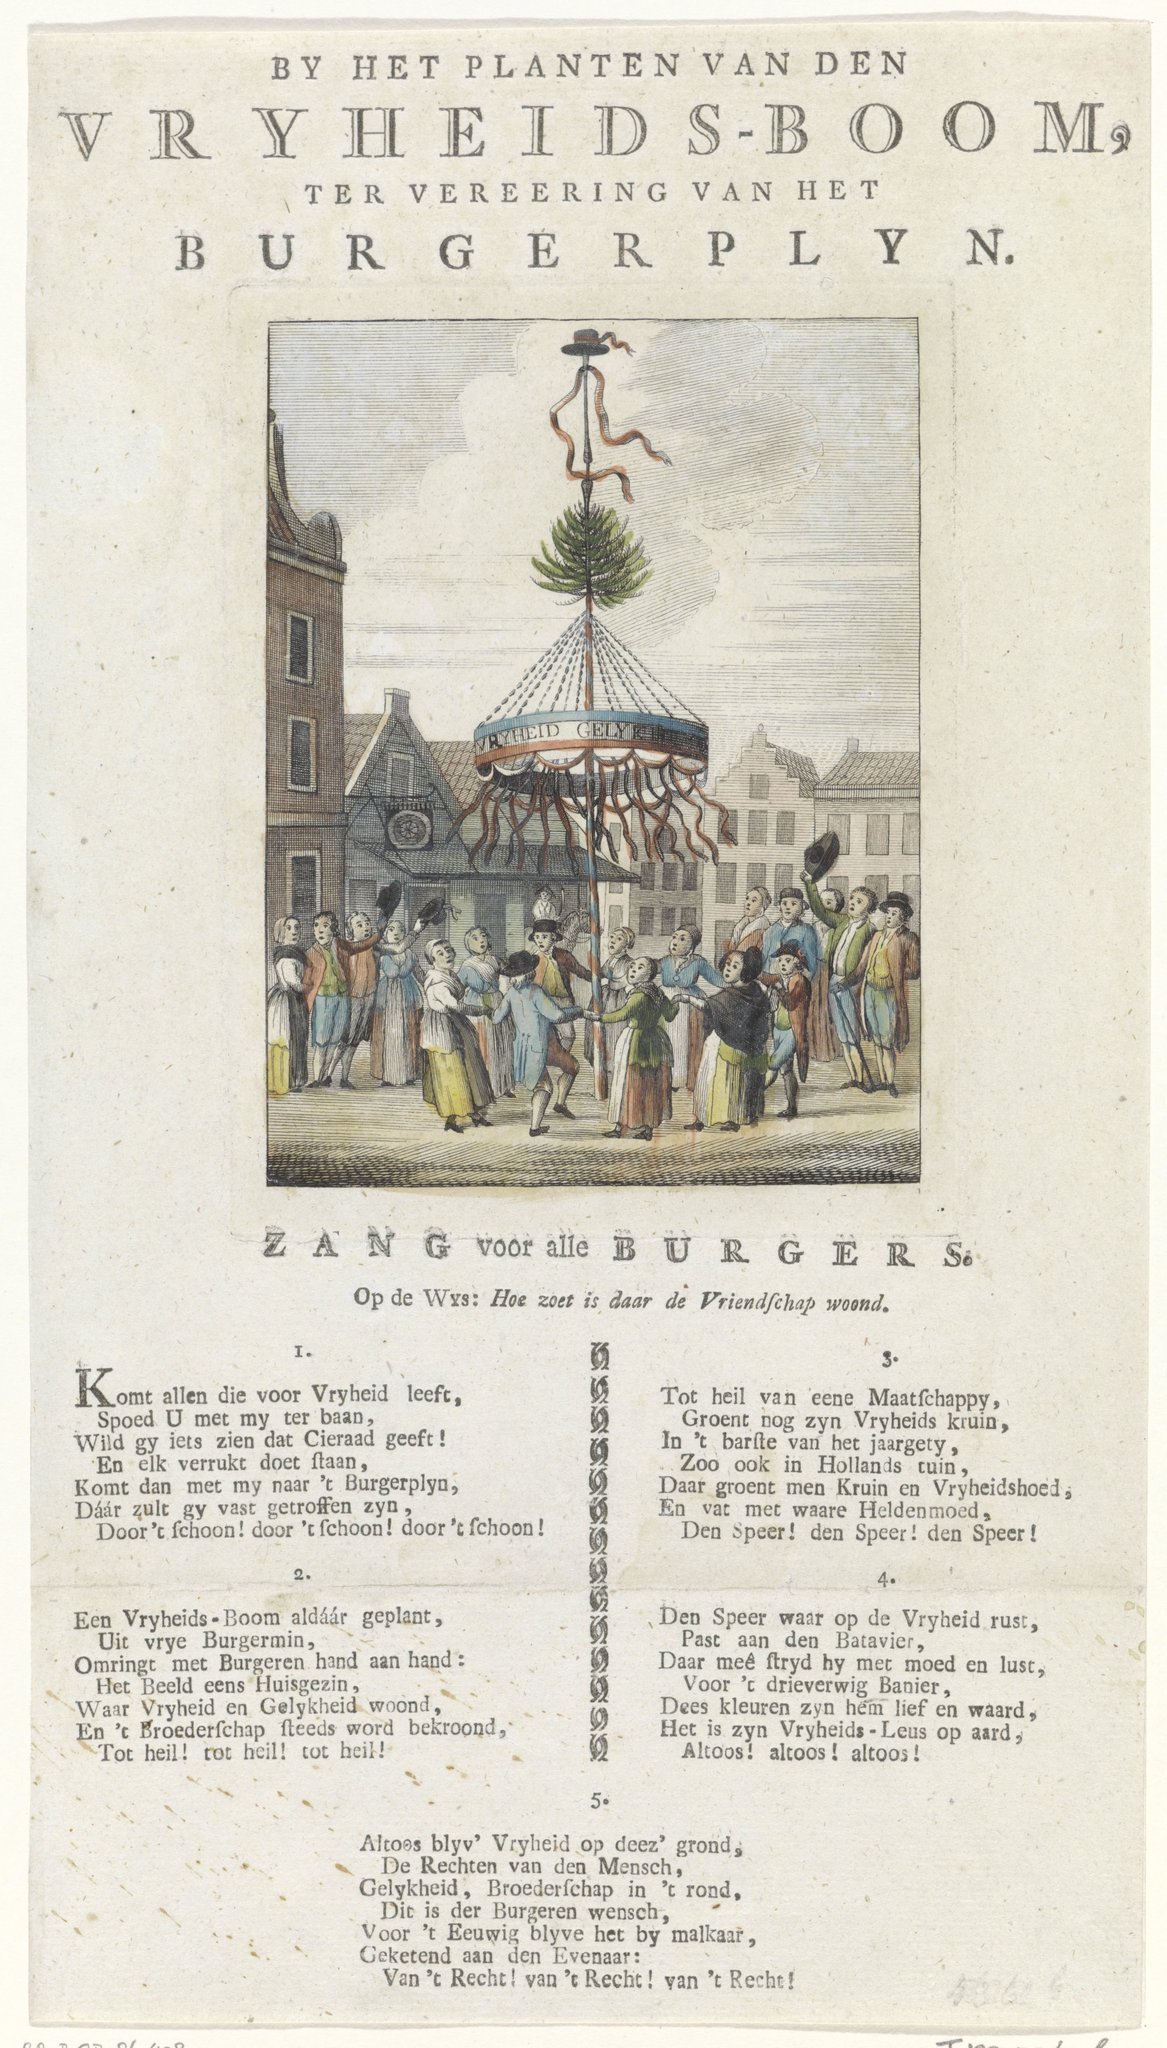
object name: print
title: Vrijheidsboom op het Koningsplein, 1795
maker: Anonymous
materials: paper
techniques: etching, hand coloring, letterpress printing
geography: netherlands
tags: dancing around the tree of liberty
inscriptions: collector's mark: Lugt 2228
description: Dansen om de Vrijheidsboom, opgericht 5-6 februari 1795 op het Koningsplein, destijds omgedoopt tot Burgerplein, te Amsterdam. Op het blad onder de plaat de tekst van een lied in vijf coupletten.